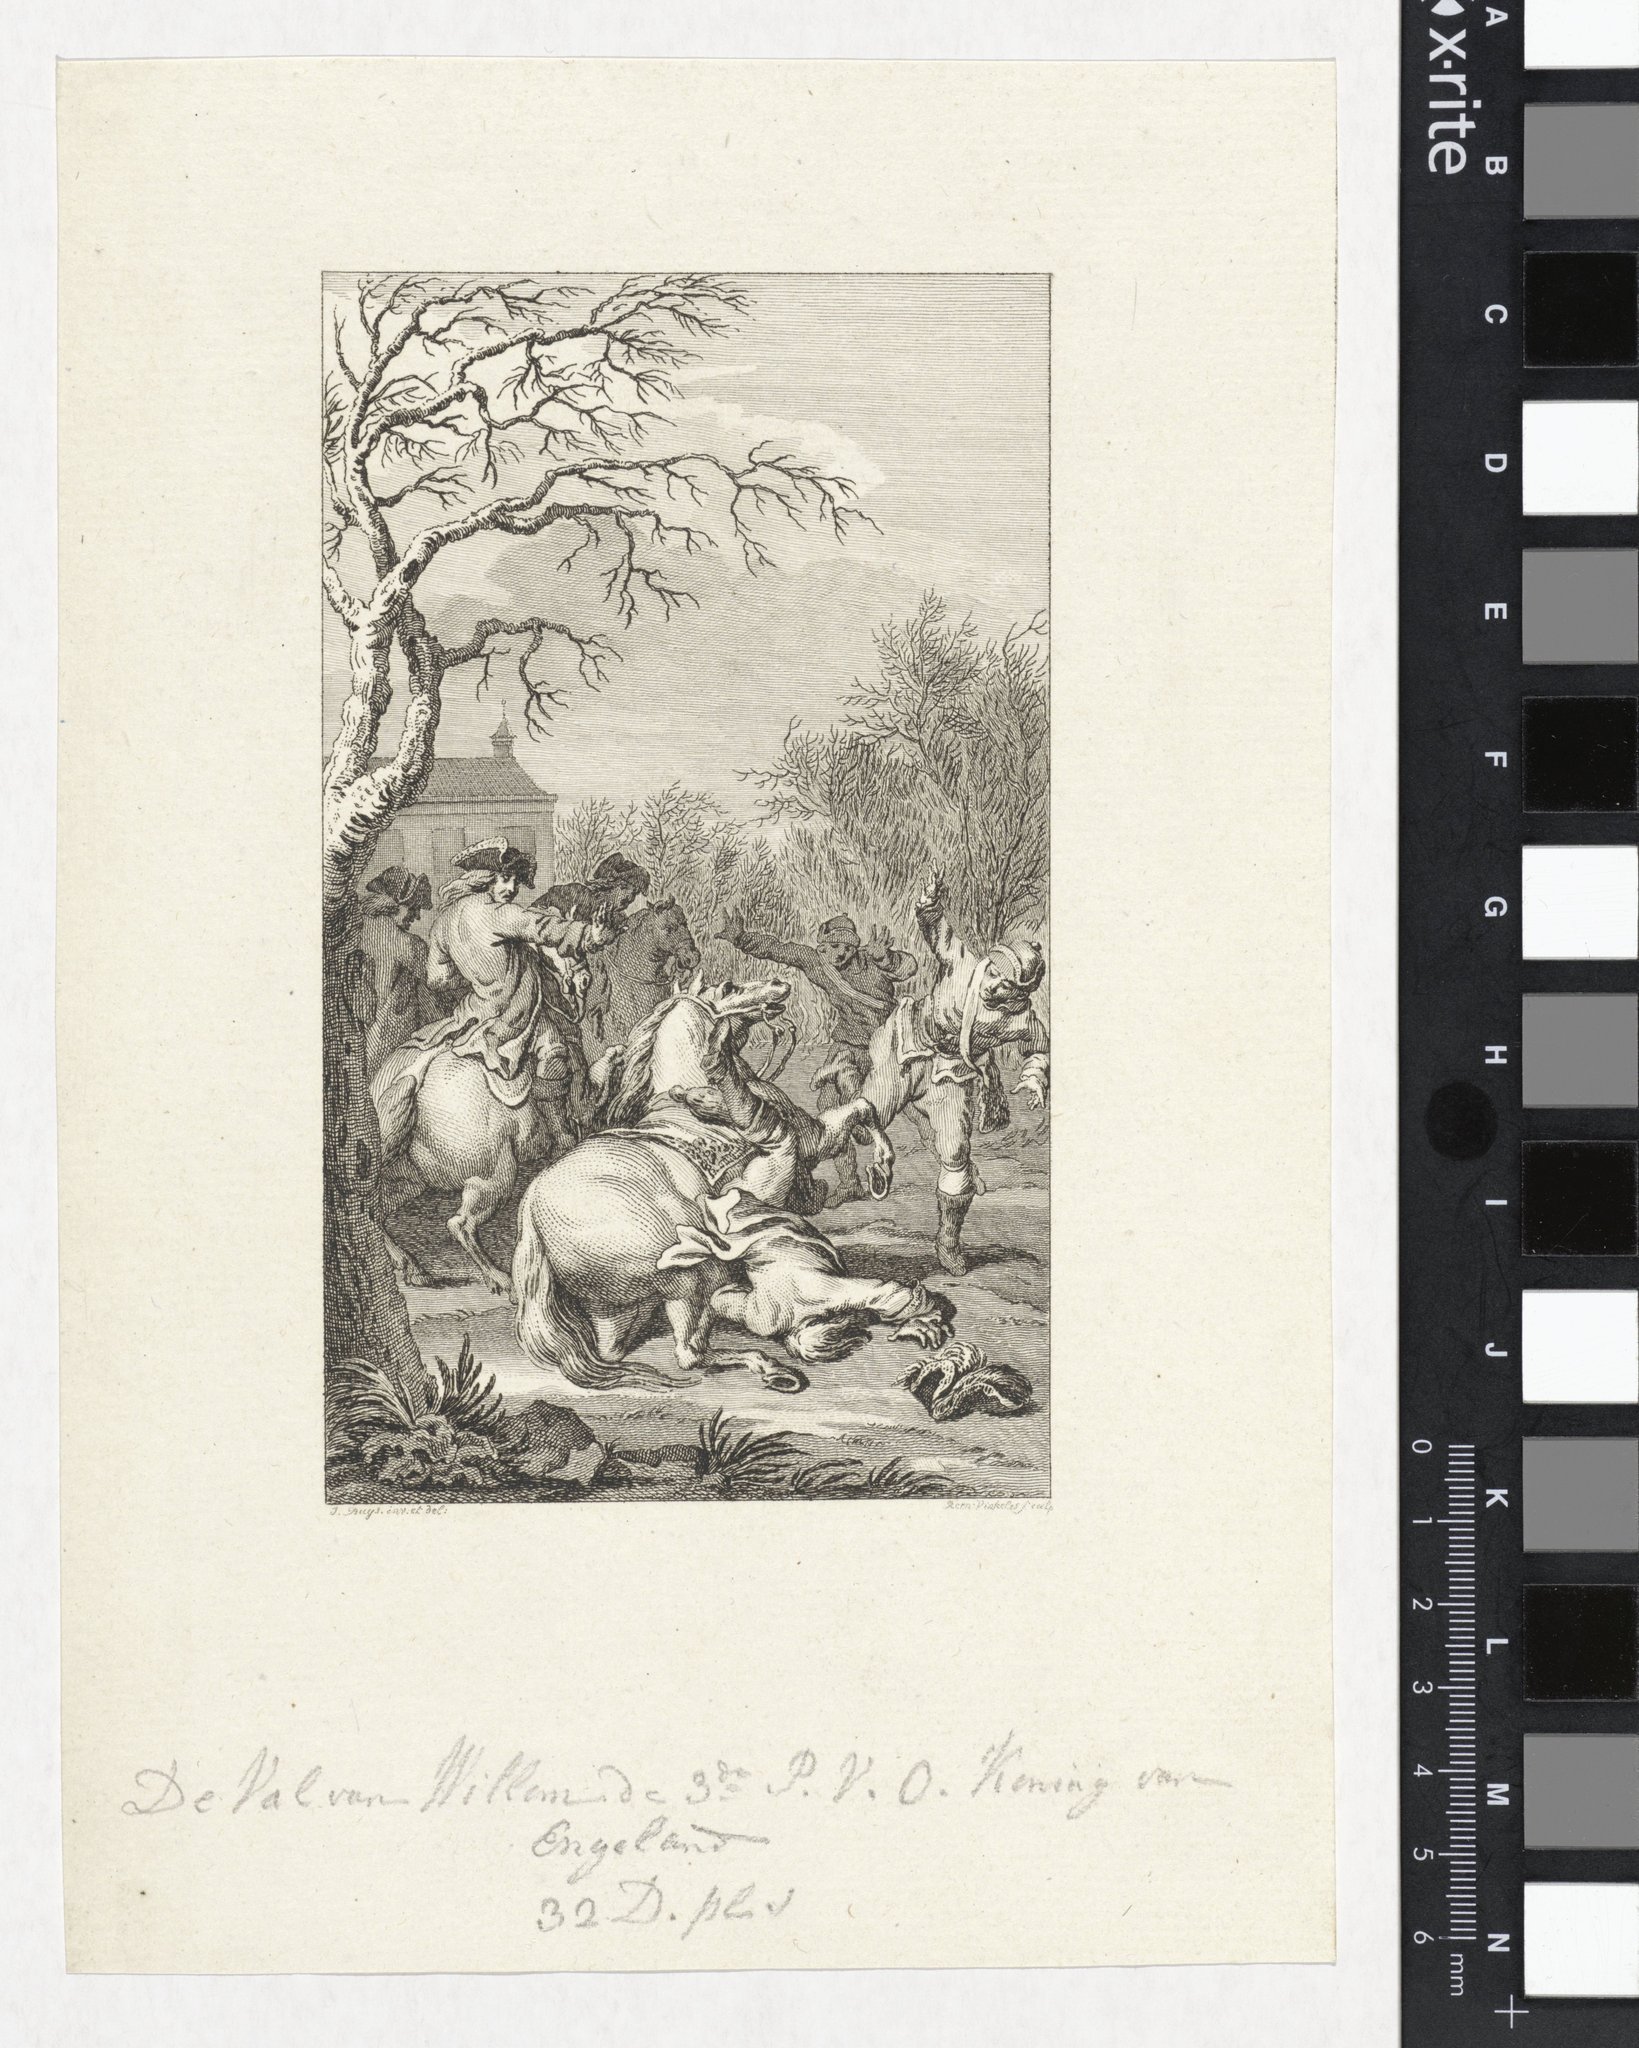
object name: print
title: De dodelijke val van Willem III tijdens een jachtpartij, 1702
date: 1794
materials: paper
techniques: etching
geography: amsterdam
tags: william iii (prince of orange and king of england, scotland, and ireland), hunting accidents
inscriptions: collector's mark: Lugt 240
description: De dodelijke val van koning Willem III tijdens een jachtpartij, 4 maart 1702. De koning valt van zijn paard, met geschrokken omstanders.